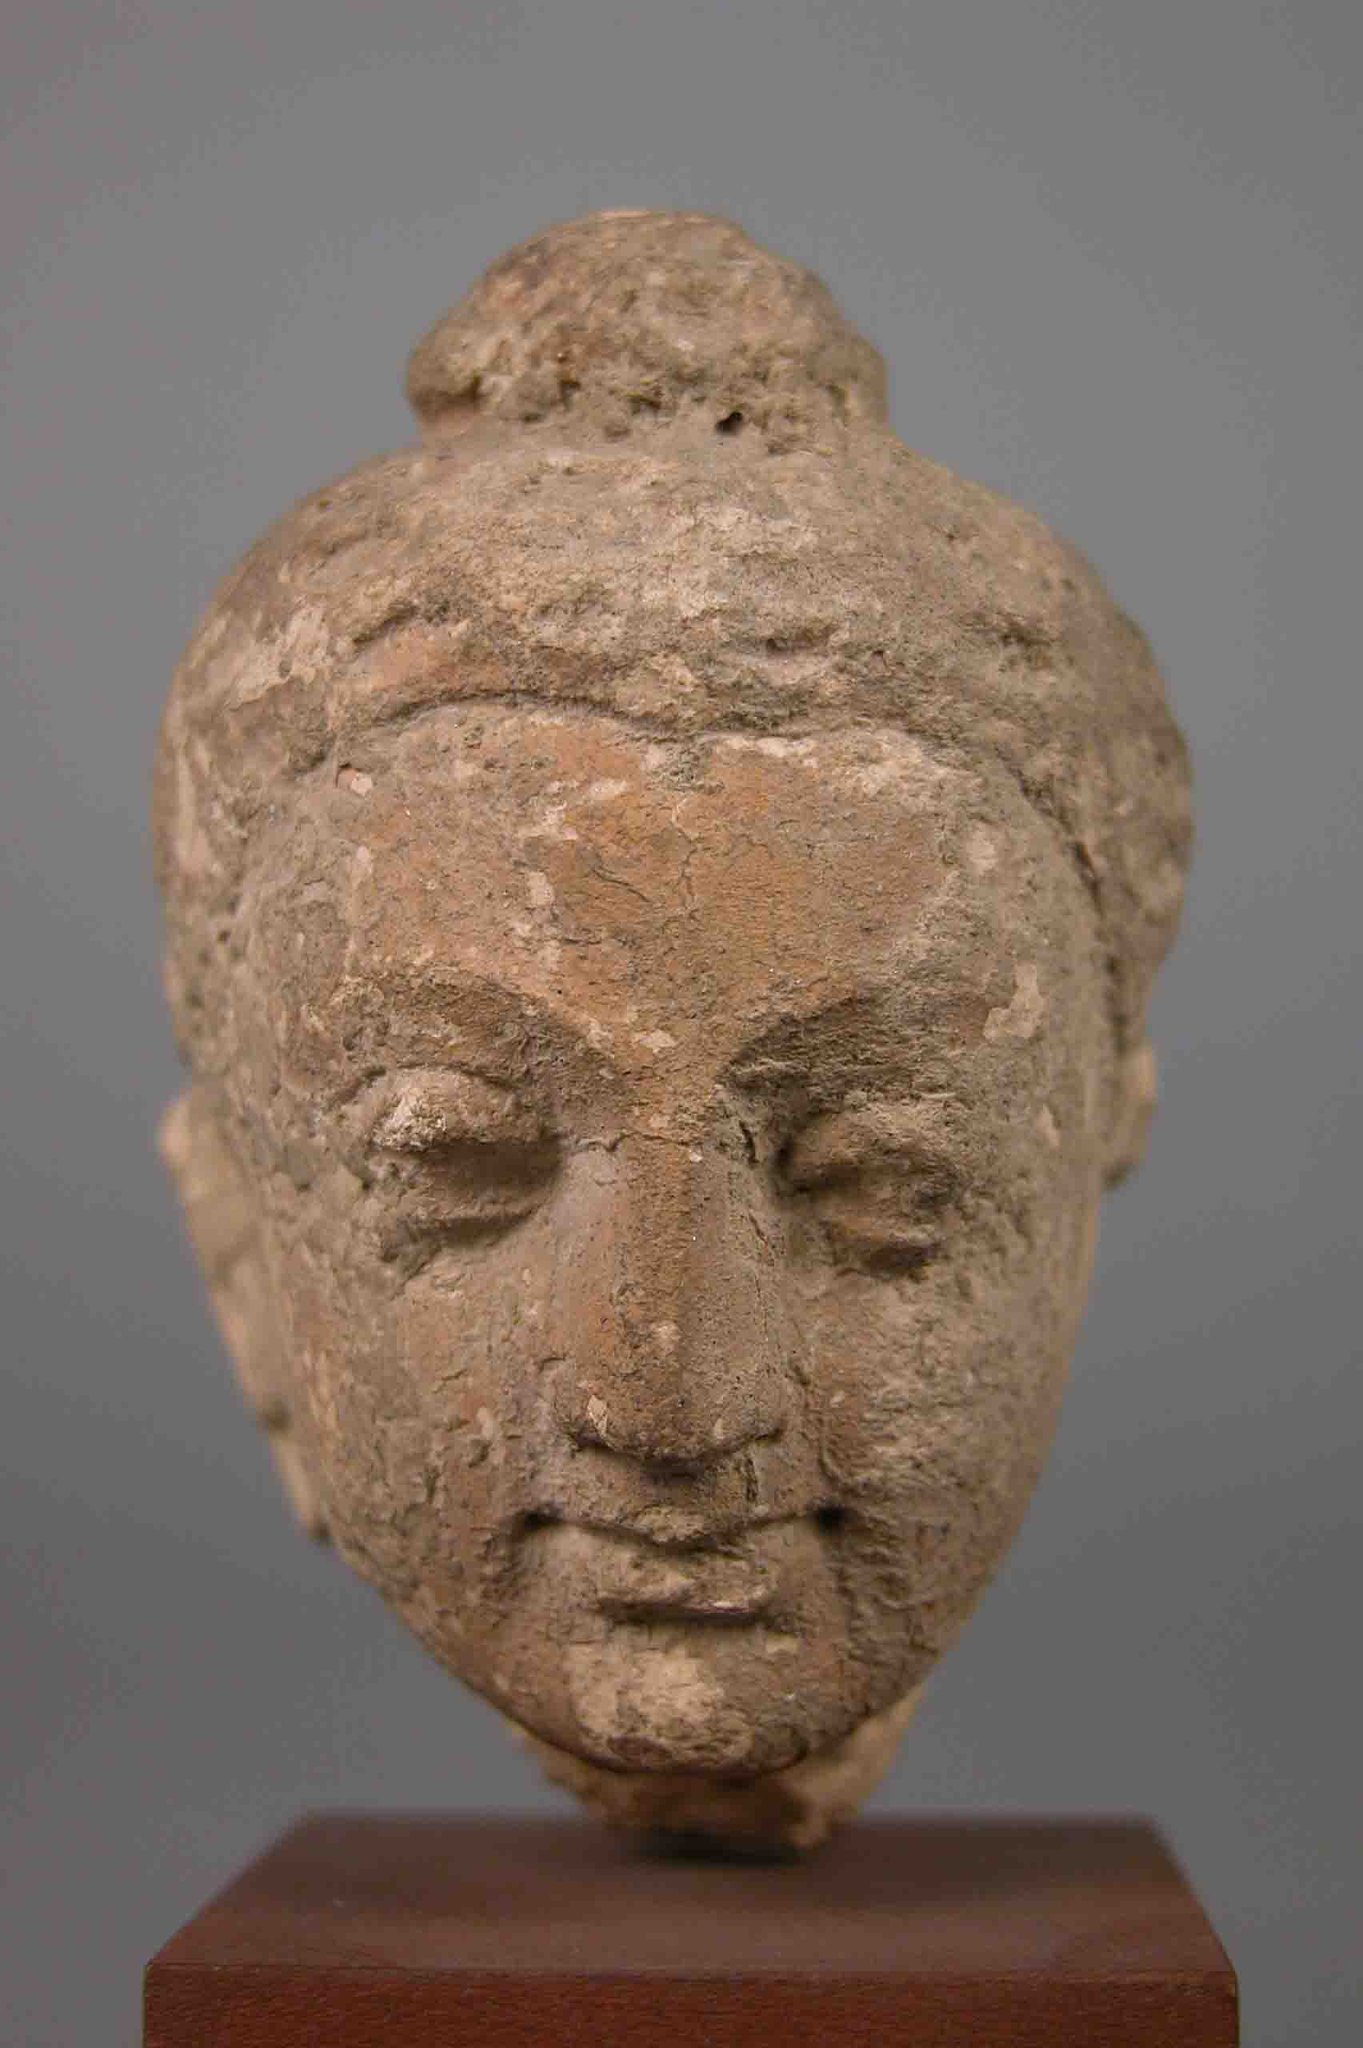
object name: head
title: Head of Buddha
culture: gandhara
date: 301-400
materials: plaster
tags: gandhara,heads,buddhism,buddha